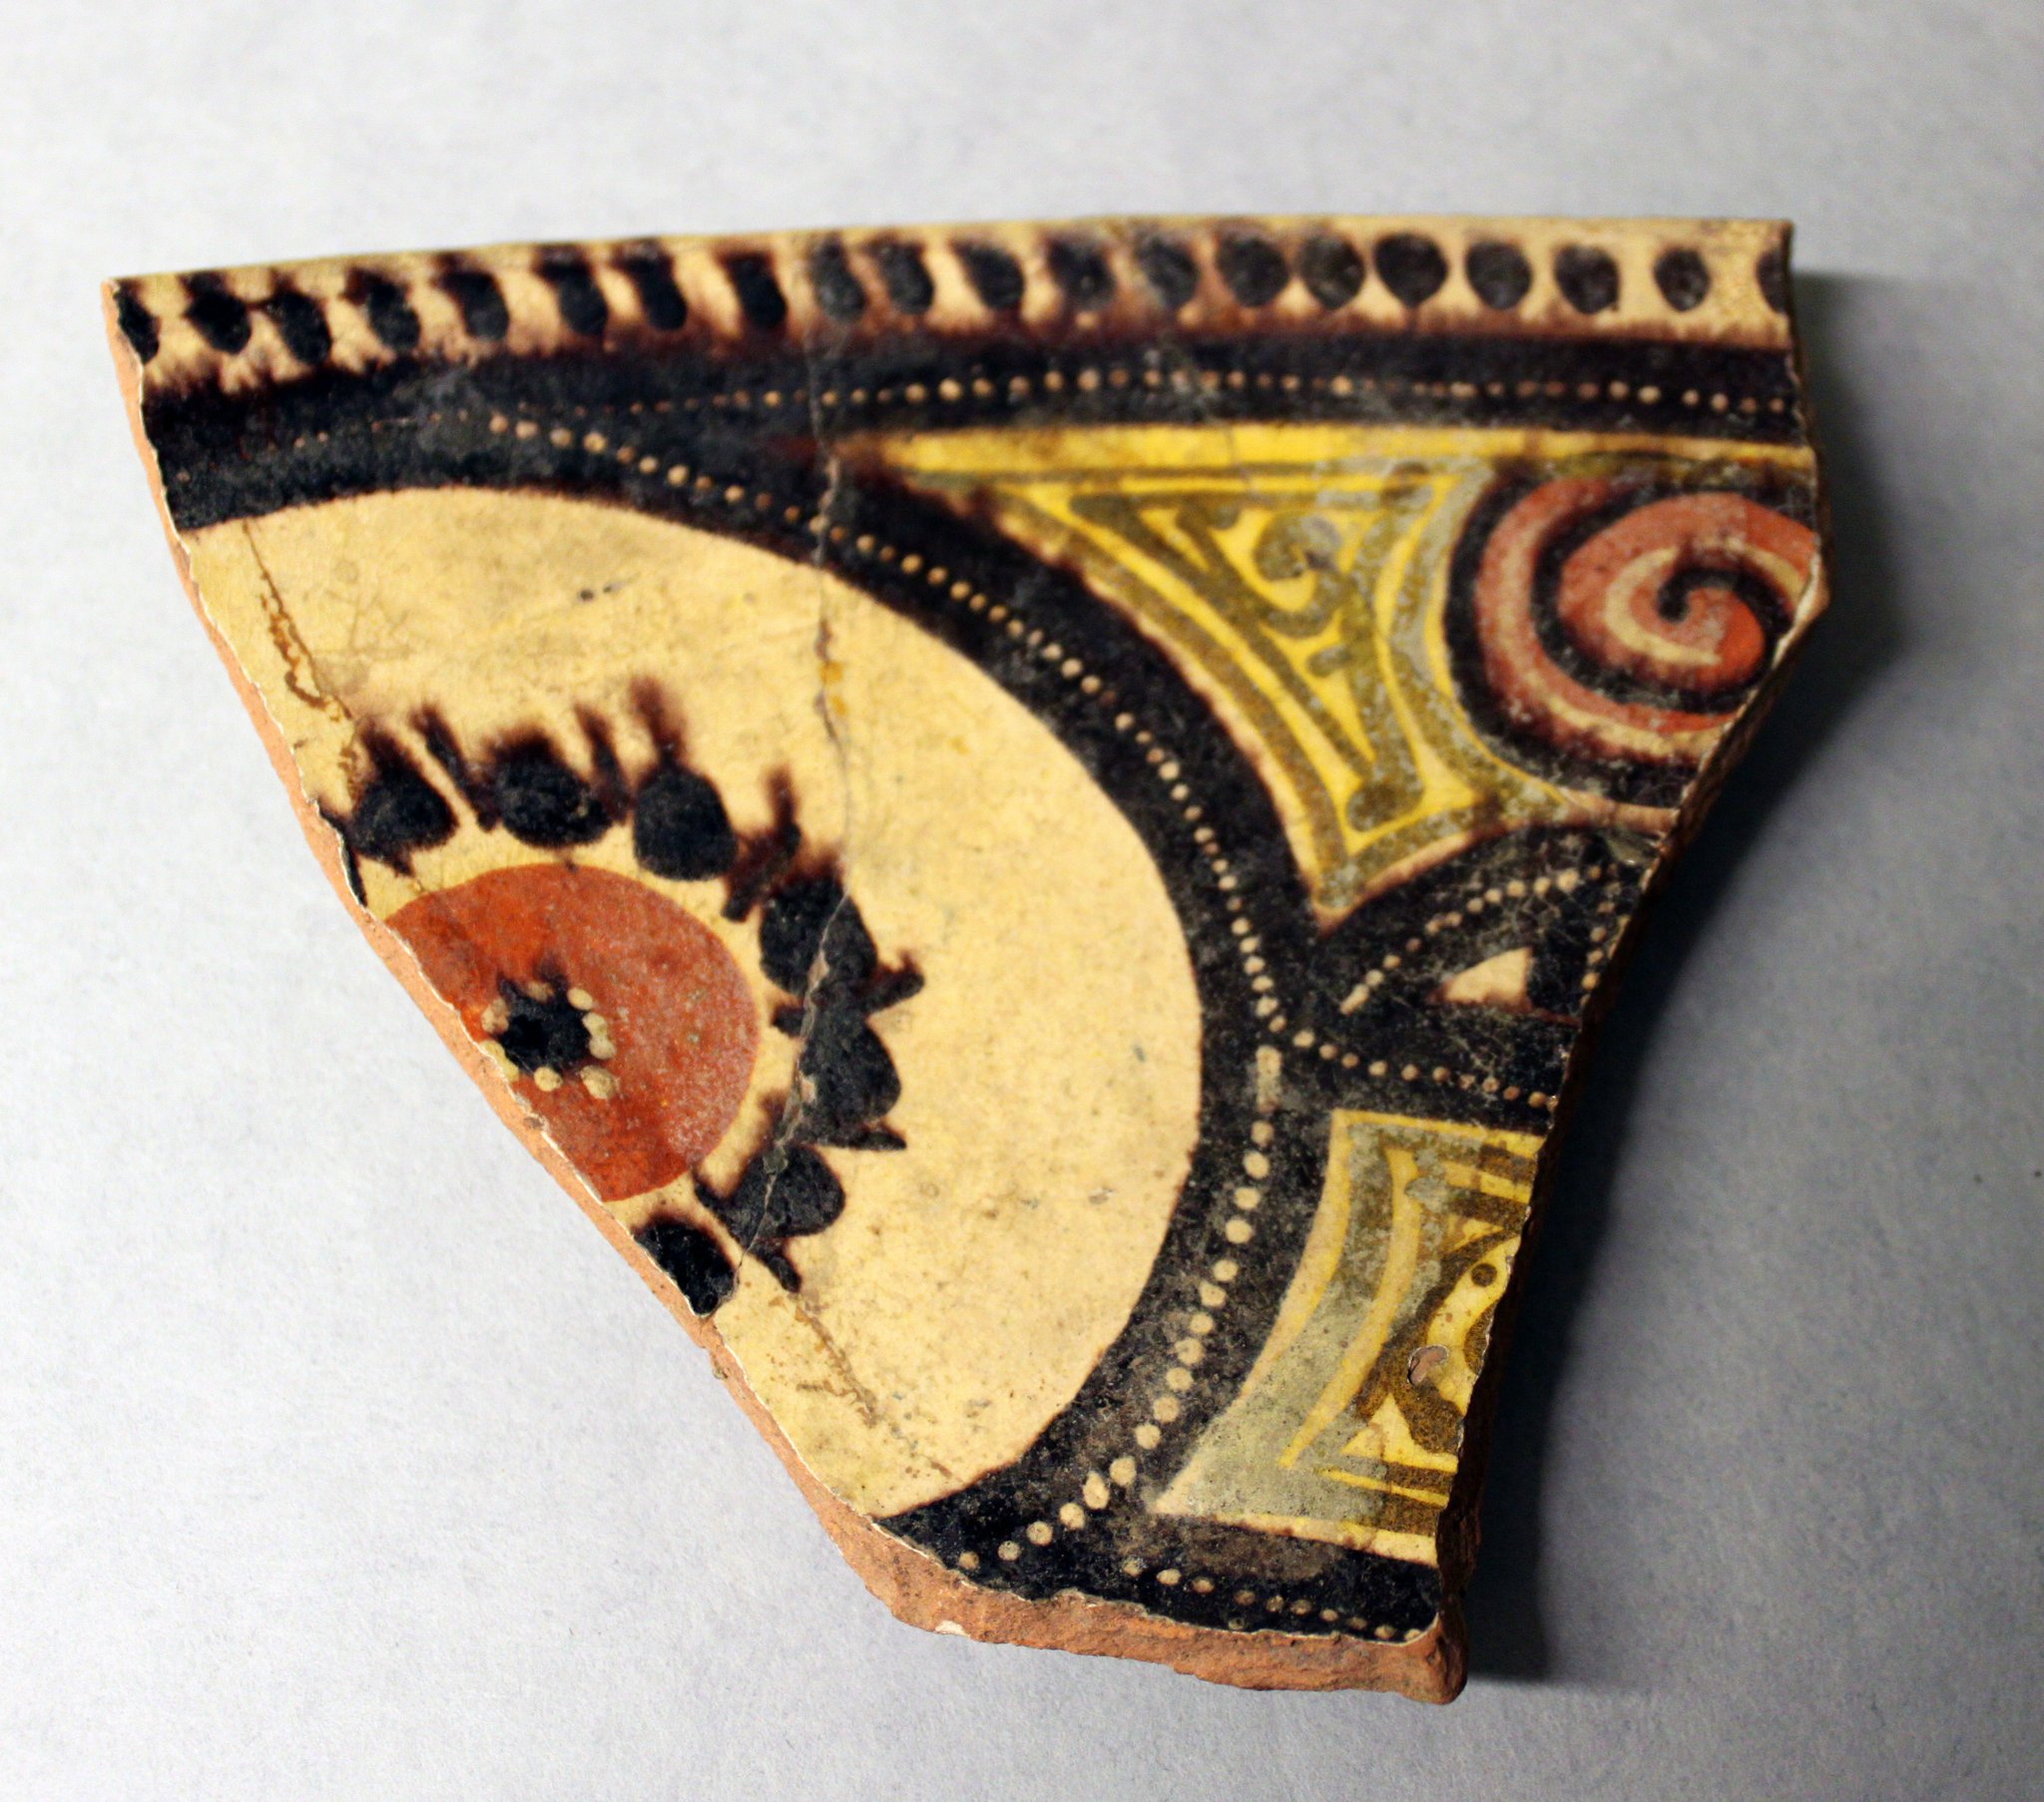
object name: fragment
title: Fragment of a Bowl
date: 801-1000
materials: earthenware, glaze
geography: iran